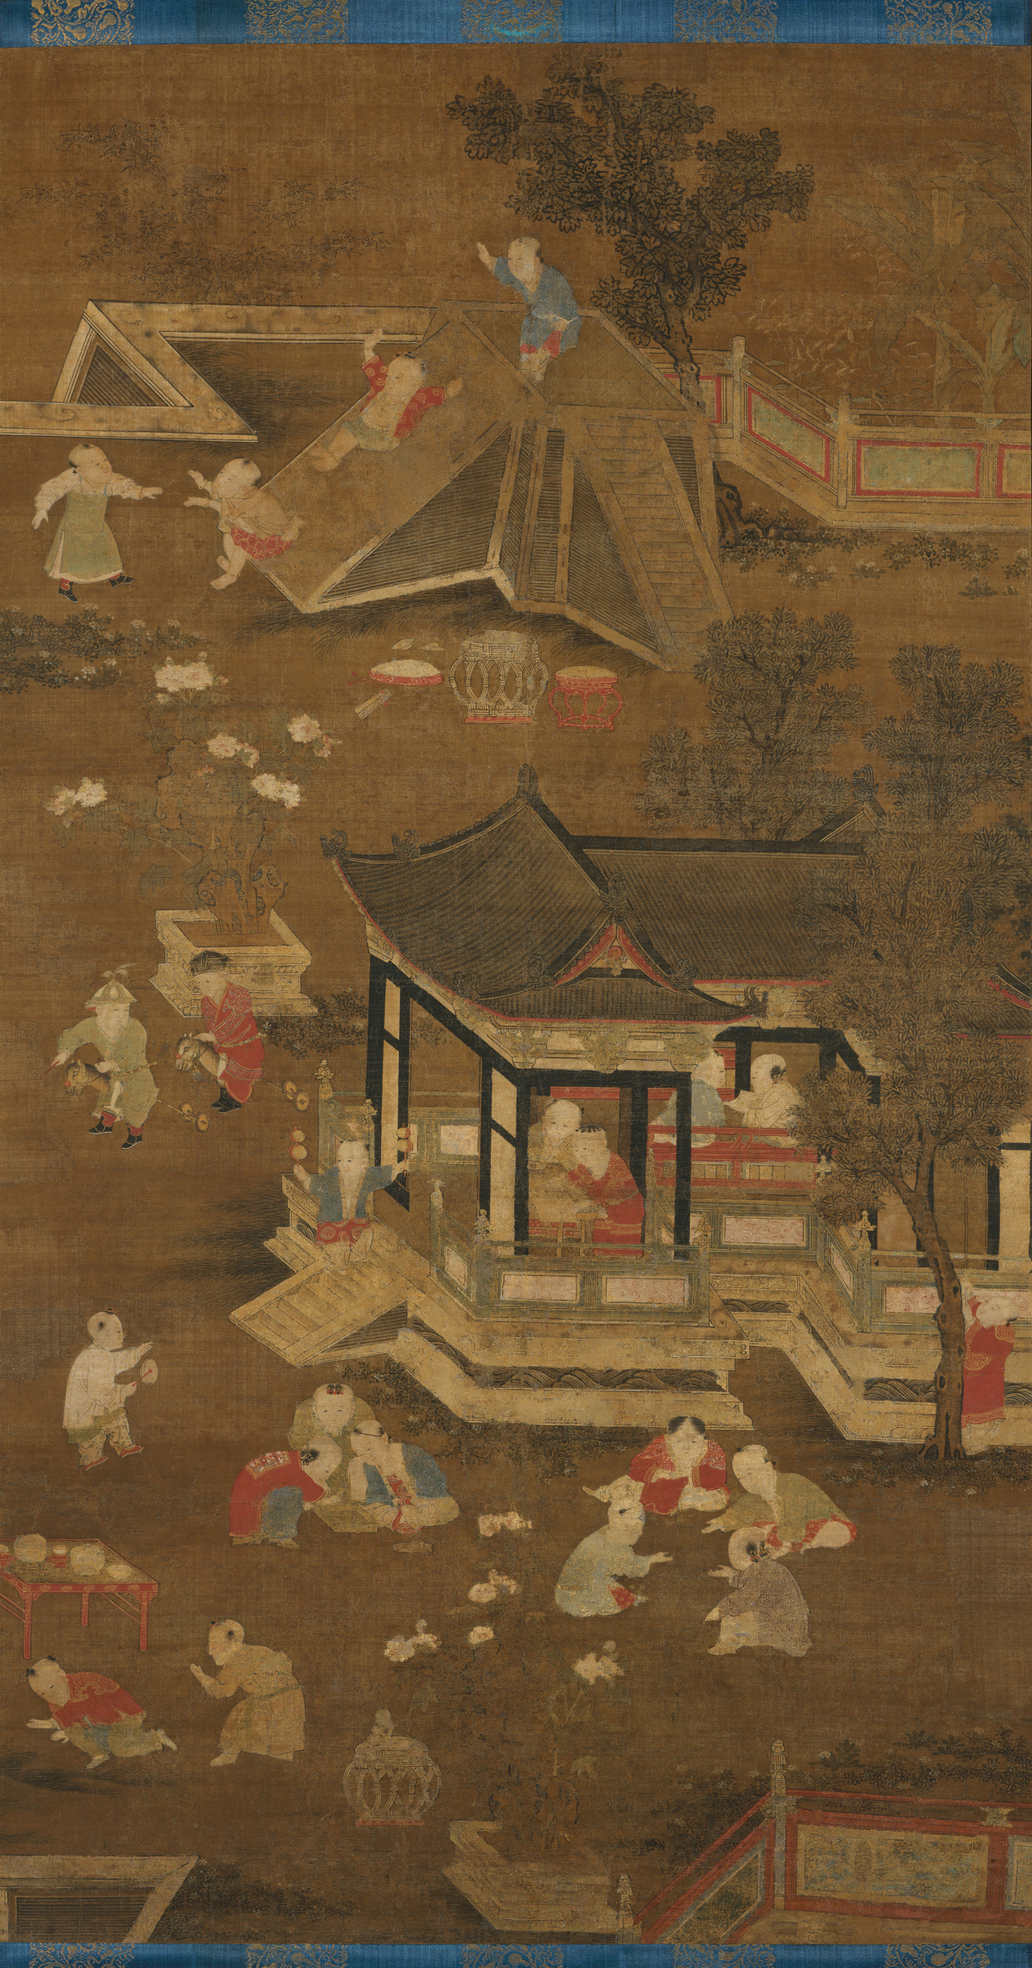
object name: hanging scroll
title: Children playing in the palace garden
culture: chinese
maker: unidentified artist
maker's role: artist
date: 1367-1500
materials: ink, silk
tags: gardens,children,playing,games,toys